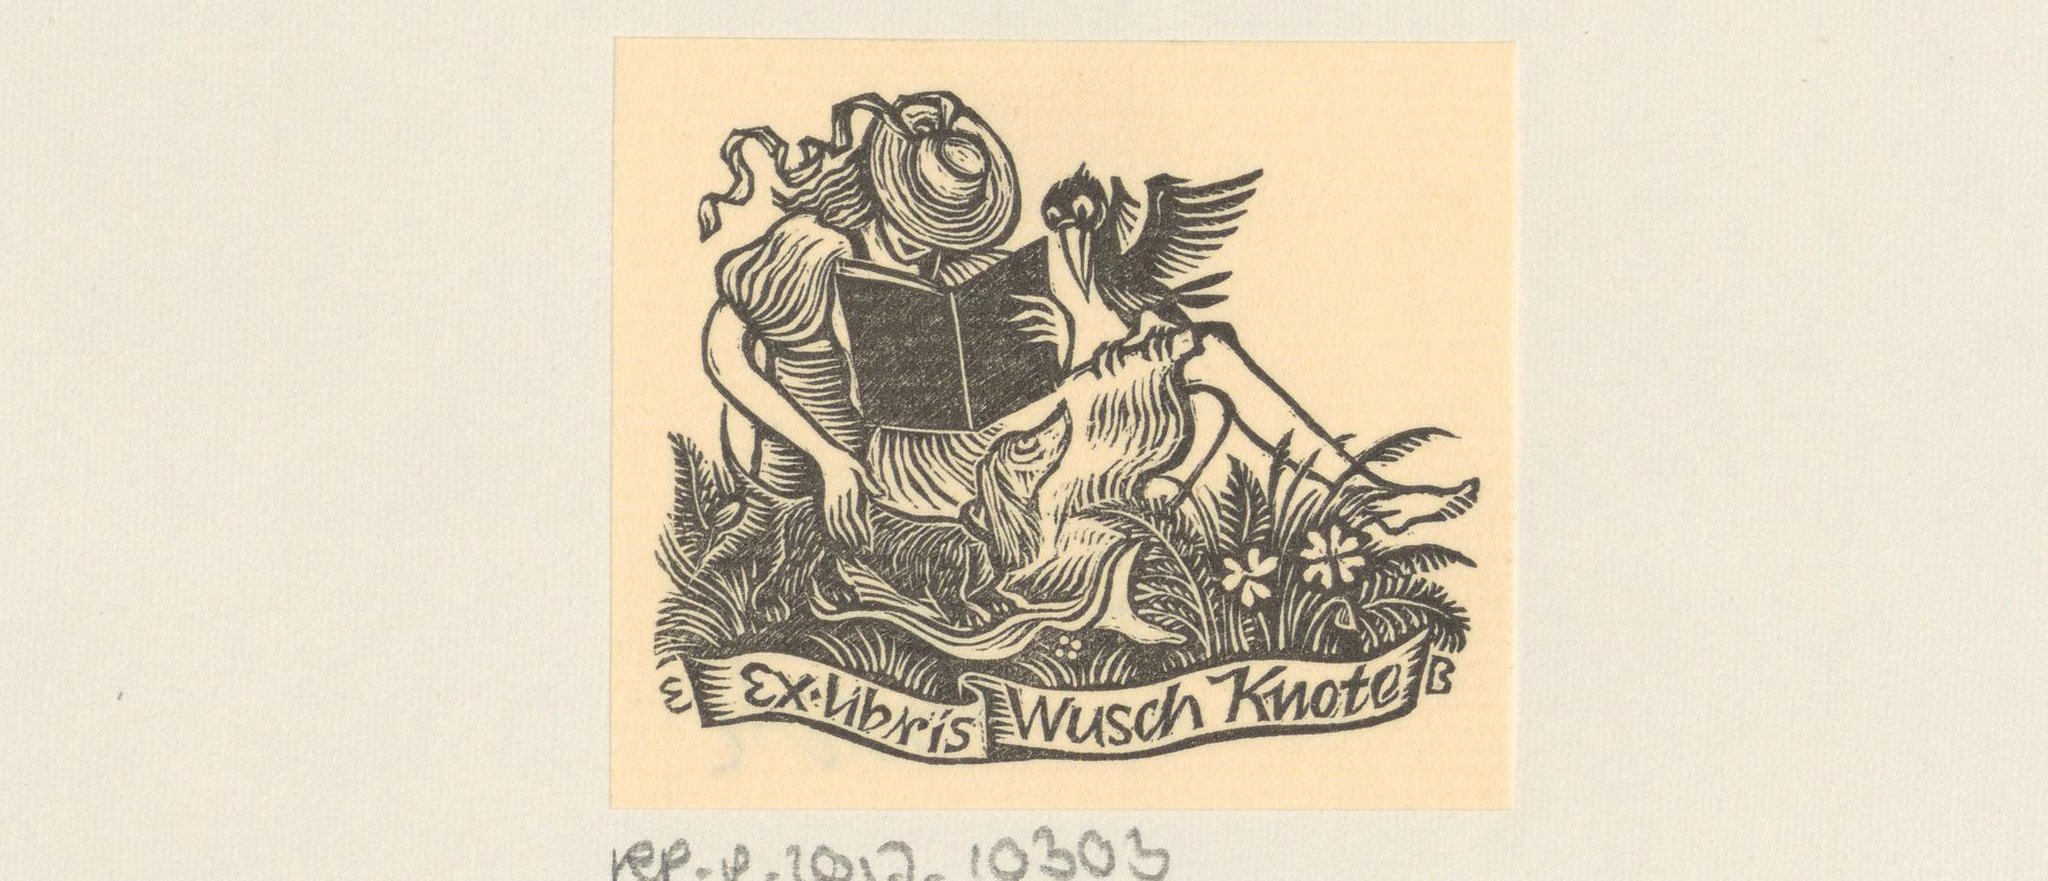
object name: bookplate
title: Ex libris van Wusch Knote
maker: ellen beck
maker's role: print maker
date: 1900-1999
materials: paper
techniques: woodcut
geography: germany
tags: sitting figure - aa - female human figure, song-birds: crow, book, dog